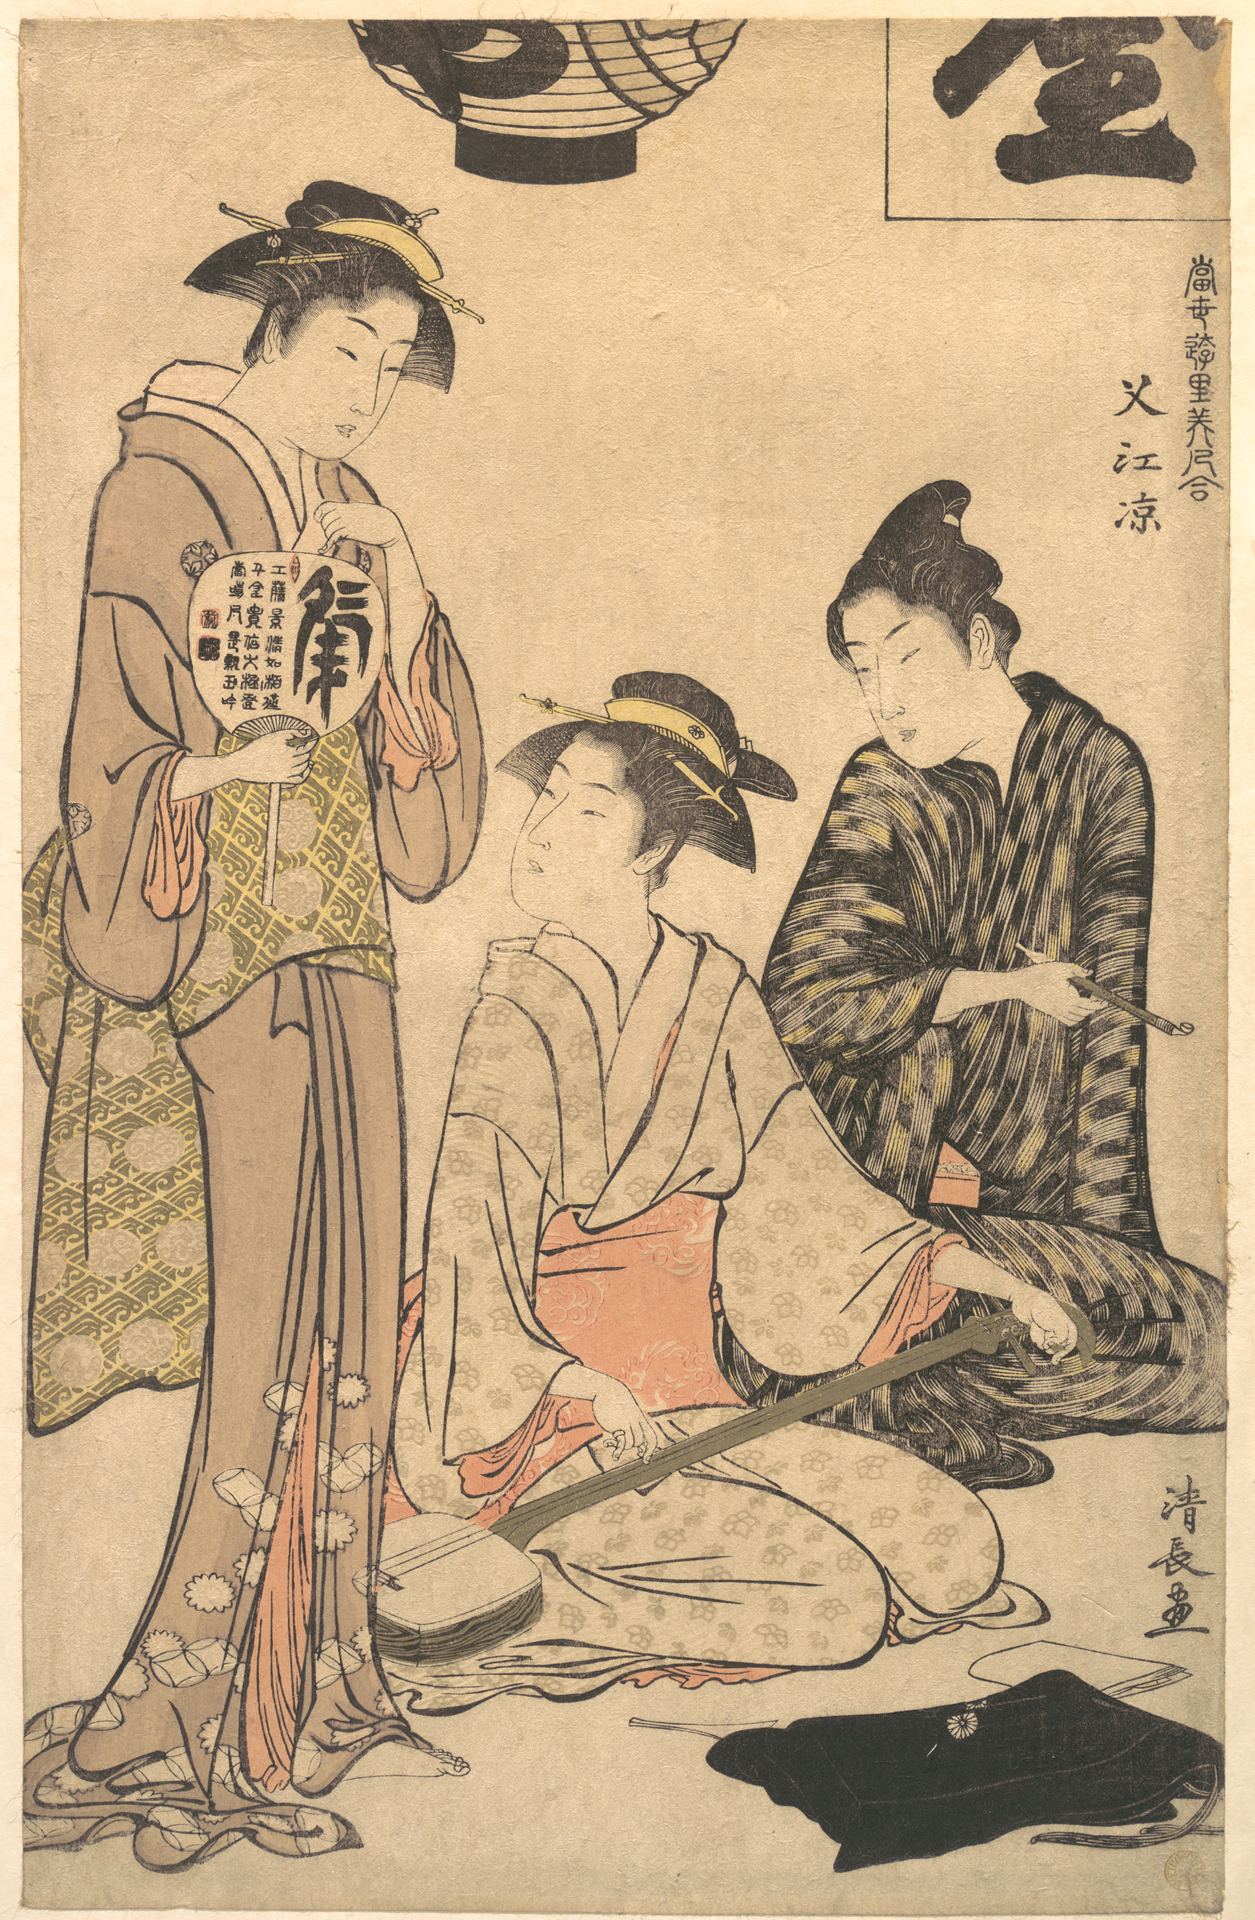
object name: print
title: Cooling off at Sashiye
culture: japanese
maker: torii kiyonaga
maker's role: artist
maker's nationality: japanese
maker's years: 1752-1815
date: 1782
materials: ink, paper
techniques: woodblock print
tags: musical instruments,men,women